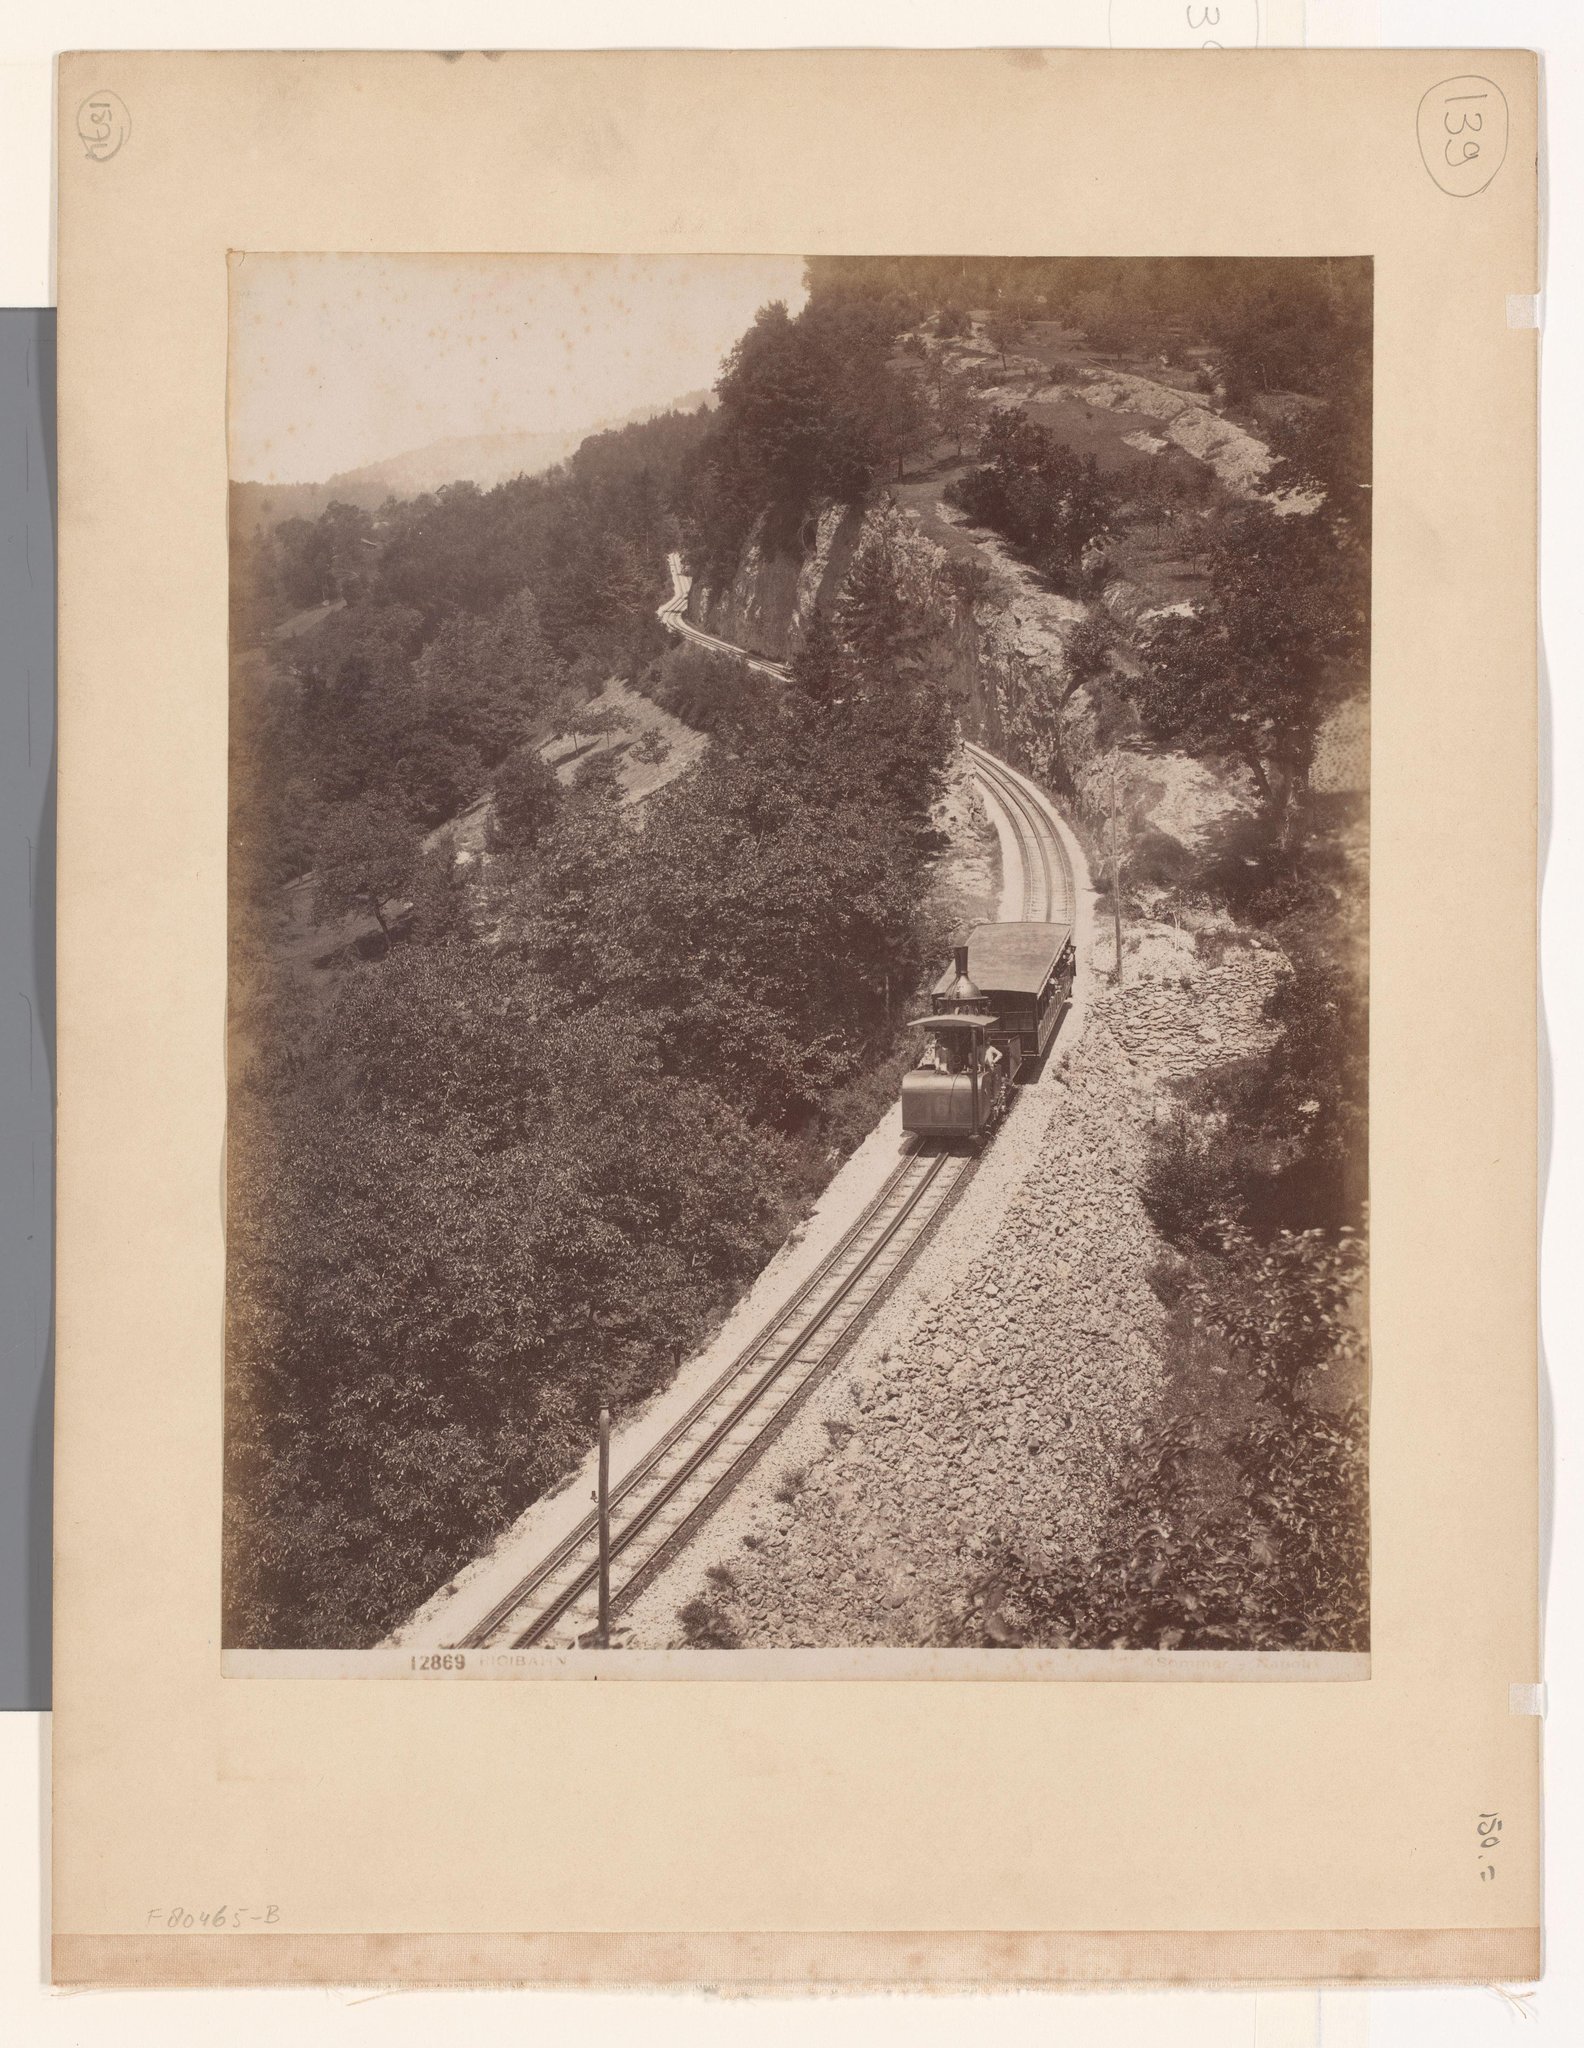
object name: photograph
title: Gezicht op een tandradtrein tussen Rigi Kulm en Vitznau, Zwitserland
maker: giorgio sommer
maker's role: fotograaf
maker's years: 1834-1914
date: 1871-1914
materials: cardboard, paper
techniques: albumen print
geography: switzerland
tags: rack railway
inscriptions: number: ‘12869’, inscription: ‘150. =’, number: ‘157’, number: ‘139’